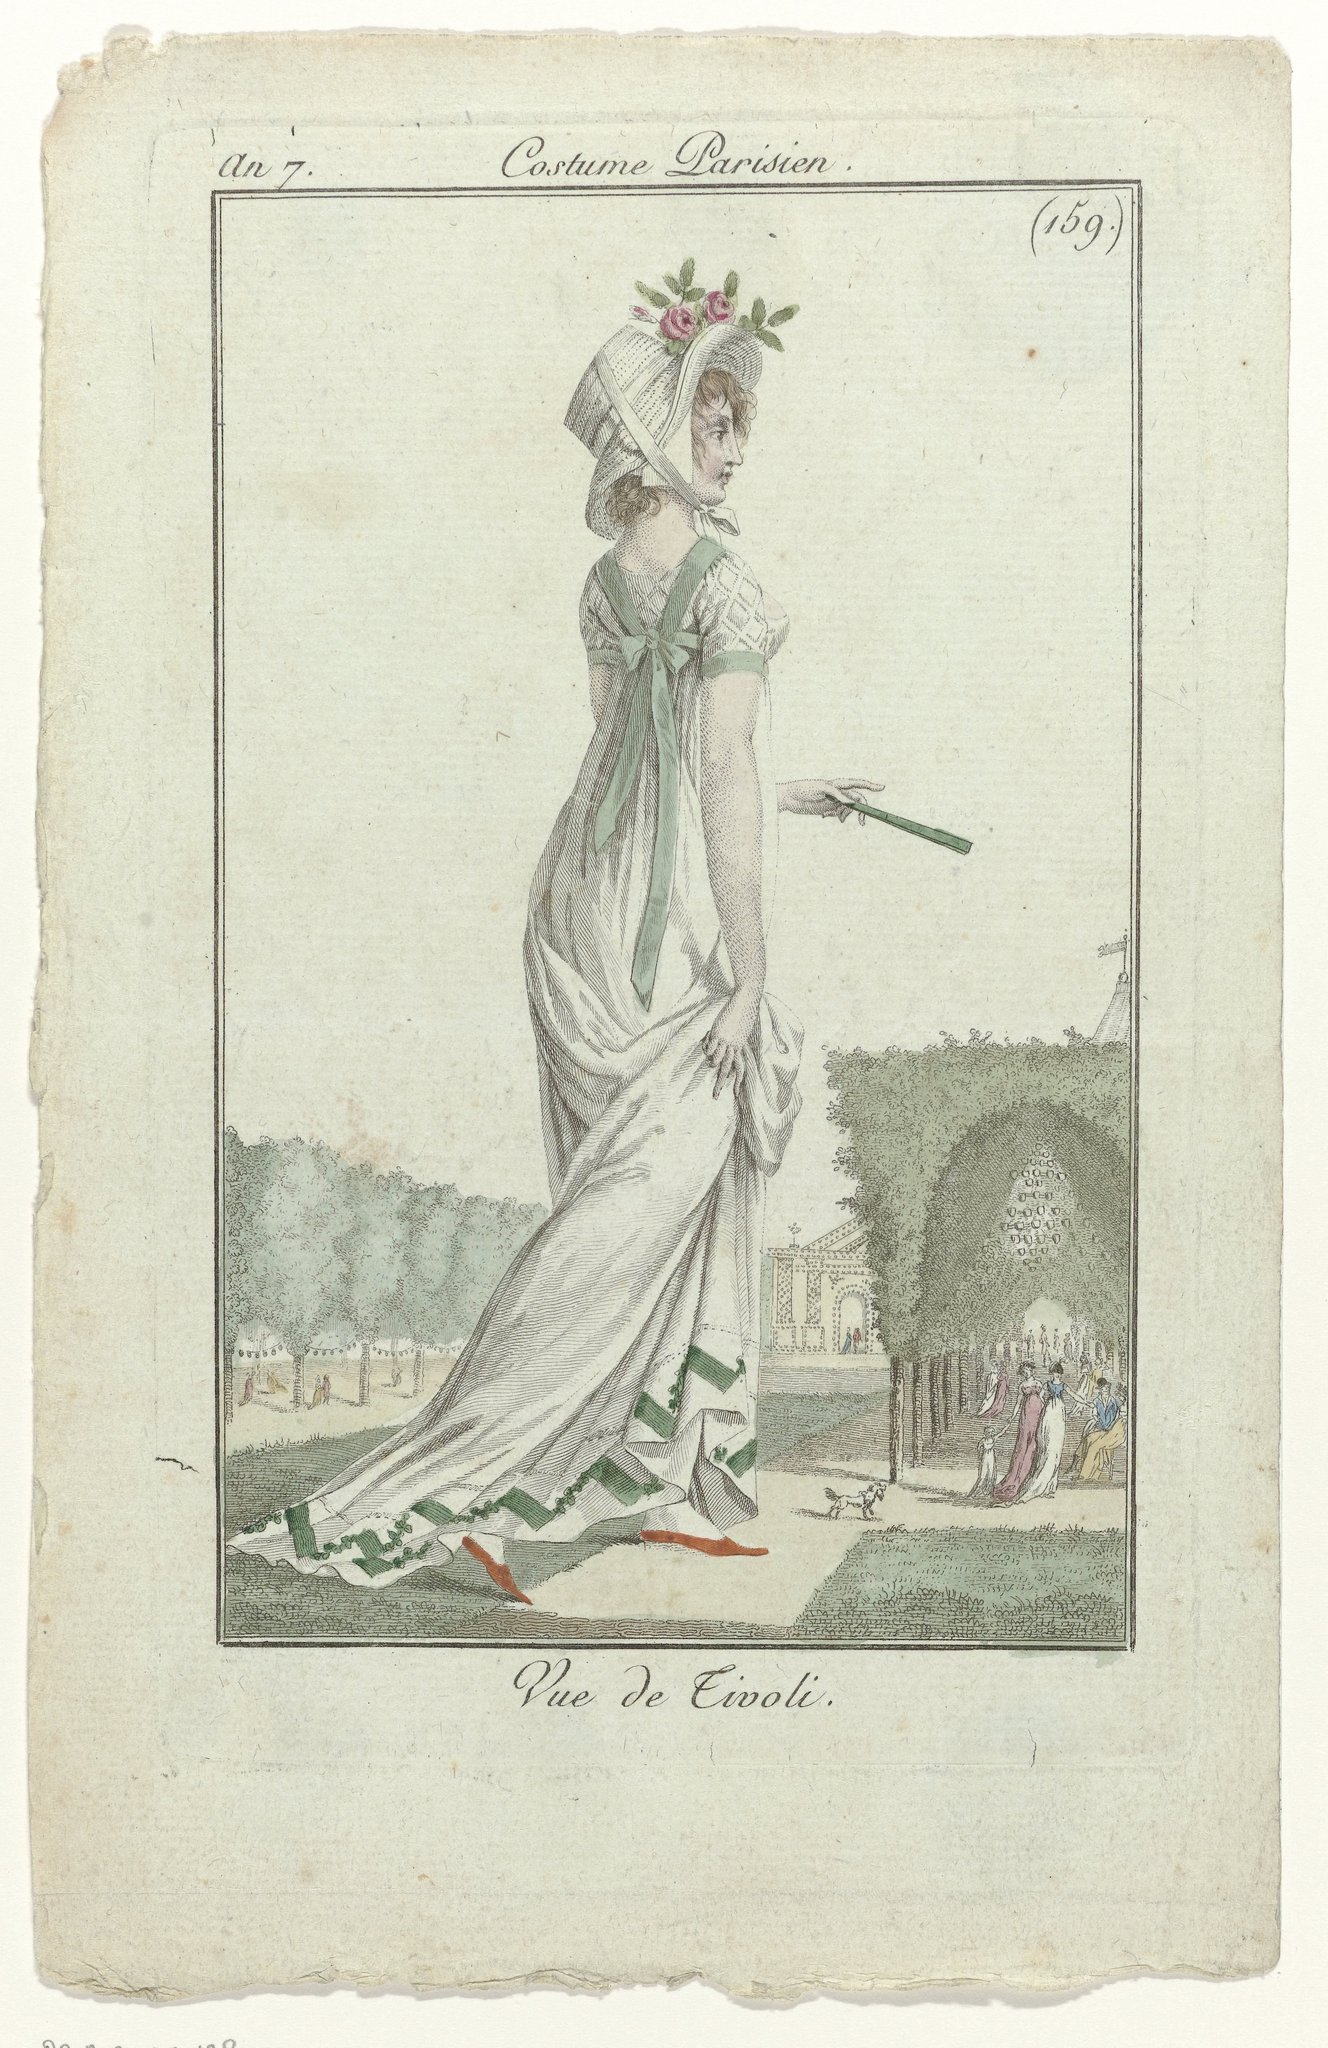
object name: fashion print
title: Journal des Dames et des Modes, Costume Parisien, 22 septembre 1799, An 7 (159) : Vue de Tivoli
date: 1799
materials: paper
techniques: engraving, hand coloring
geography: paris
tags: head-gear (+ women's clothes), garden, fashion plates, shoes, sandals (+ women's clothes), dress, gown (+ women's clothes), fan (+ women's clothes)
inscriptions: title: ‘Costume Parisien.’, caption: ‘Vue de Tivoli’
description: Japon met een geruit lijfje. Gestrikt lint op de rug, zoom versierd met een geometrisch motief. Korte mouwen en sleep. Accessoires: hoed versierd met bloemen, waaier, platte schoenen met puntige neuzen. De prent maakt deel uit van het modetijdschrift Journal des Dames et des Modes, uitgegeven door Pierre de la Mésangère, Parijs, 1797-1839